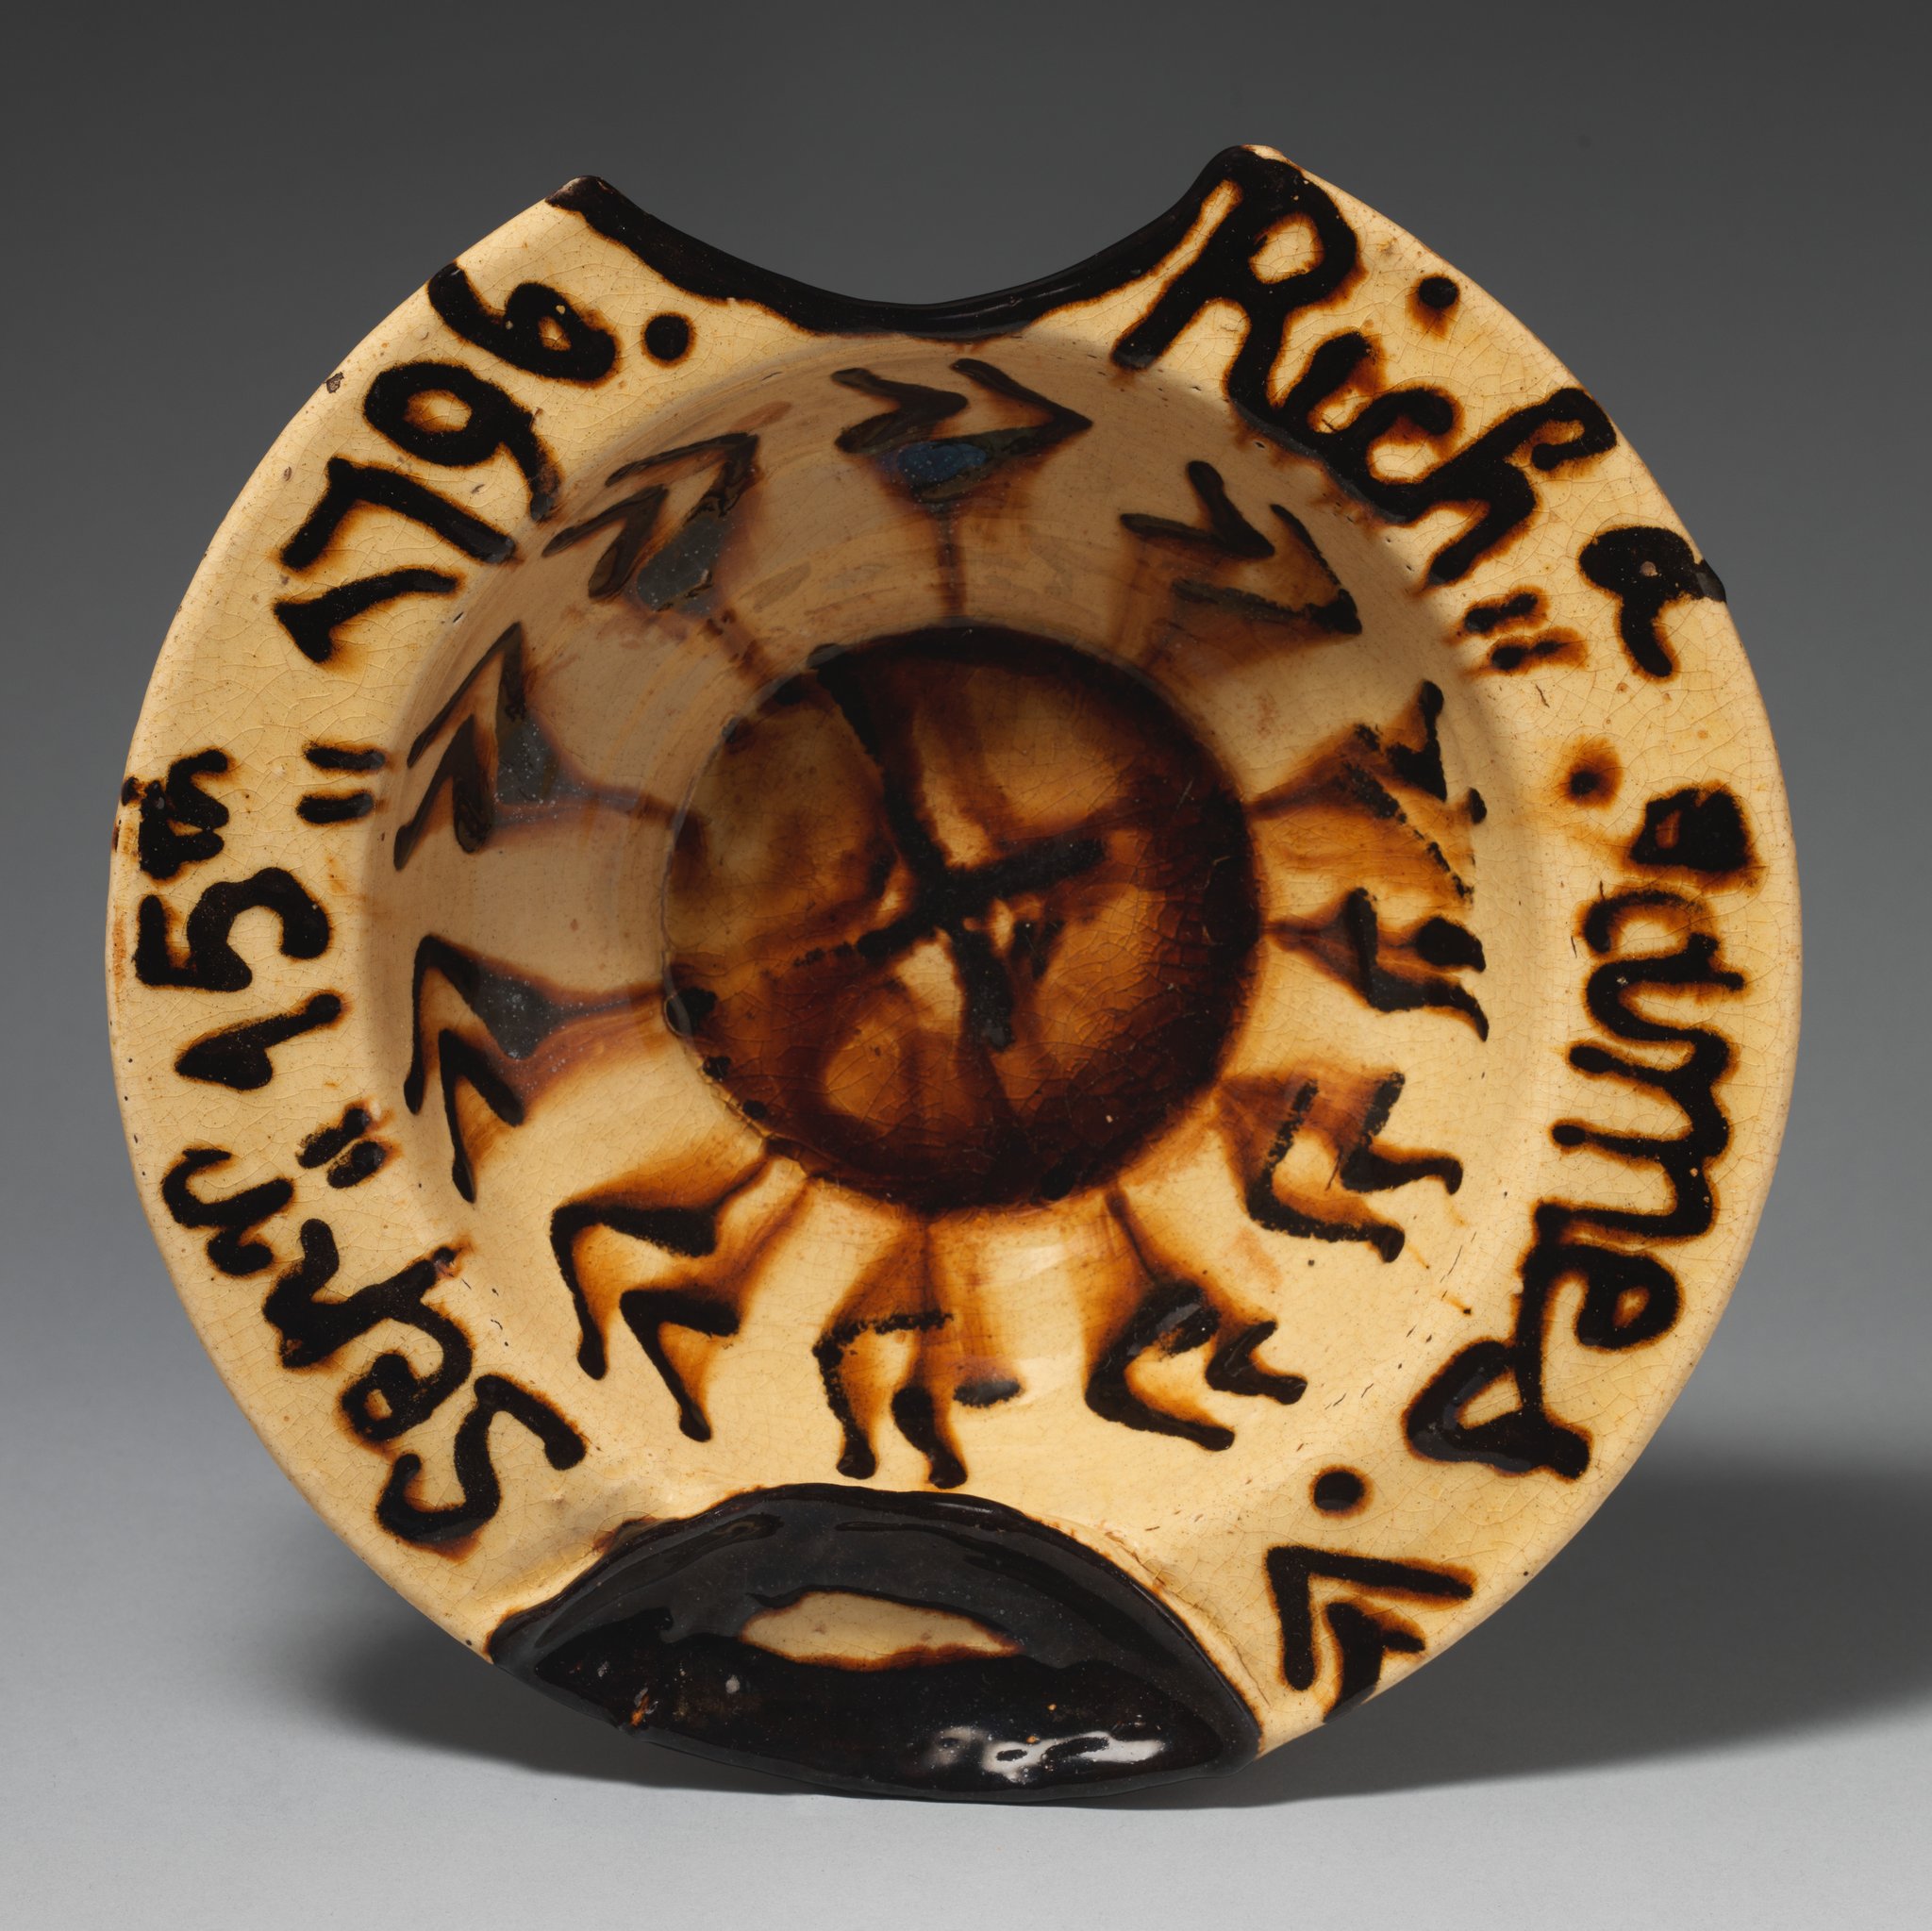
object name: barber's basin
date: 1796